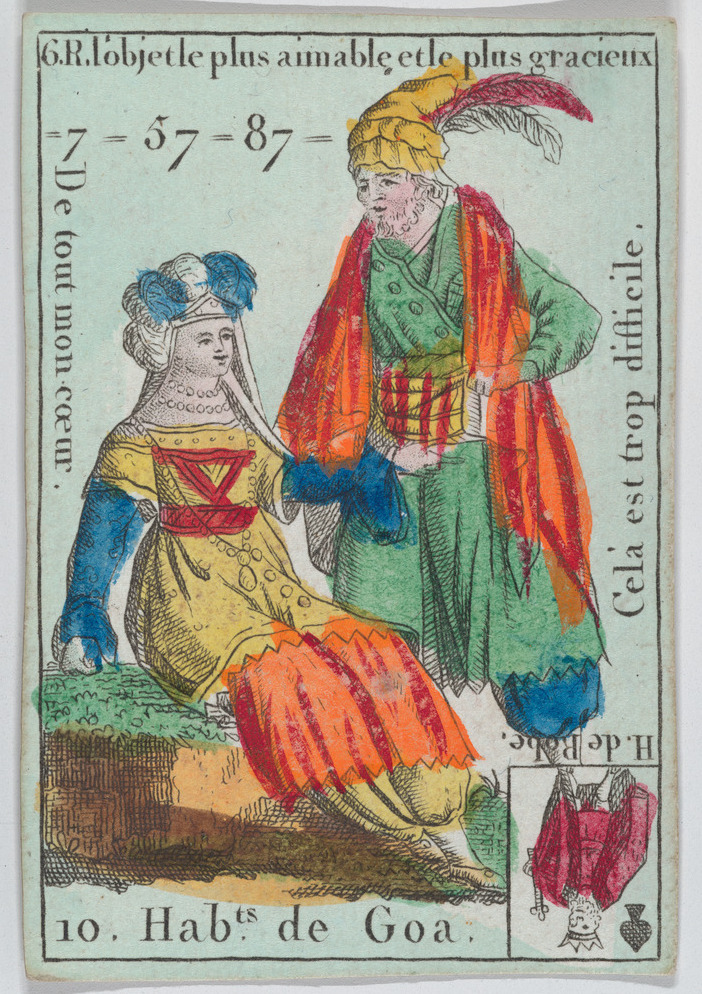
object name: print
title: Hab.ts de Goa from playing cards "Jeu d'Or"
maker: anonymous, french, 18th century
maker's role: artist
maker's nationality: french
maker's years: 1700-1800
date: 1700-1799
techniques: etching, hand coloring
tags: men,portraits,women,playing cards